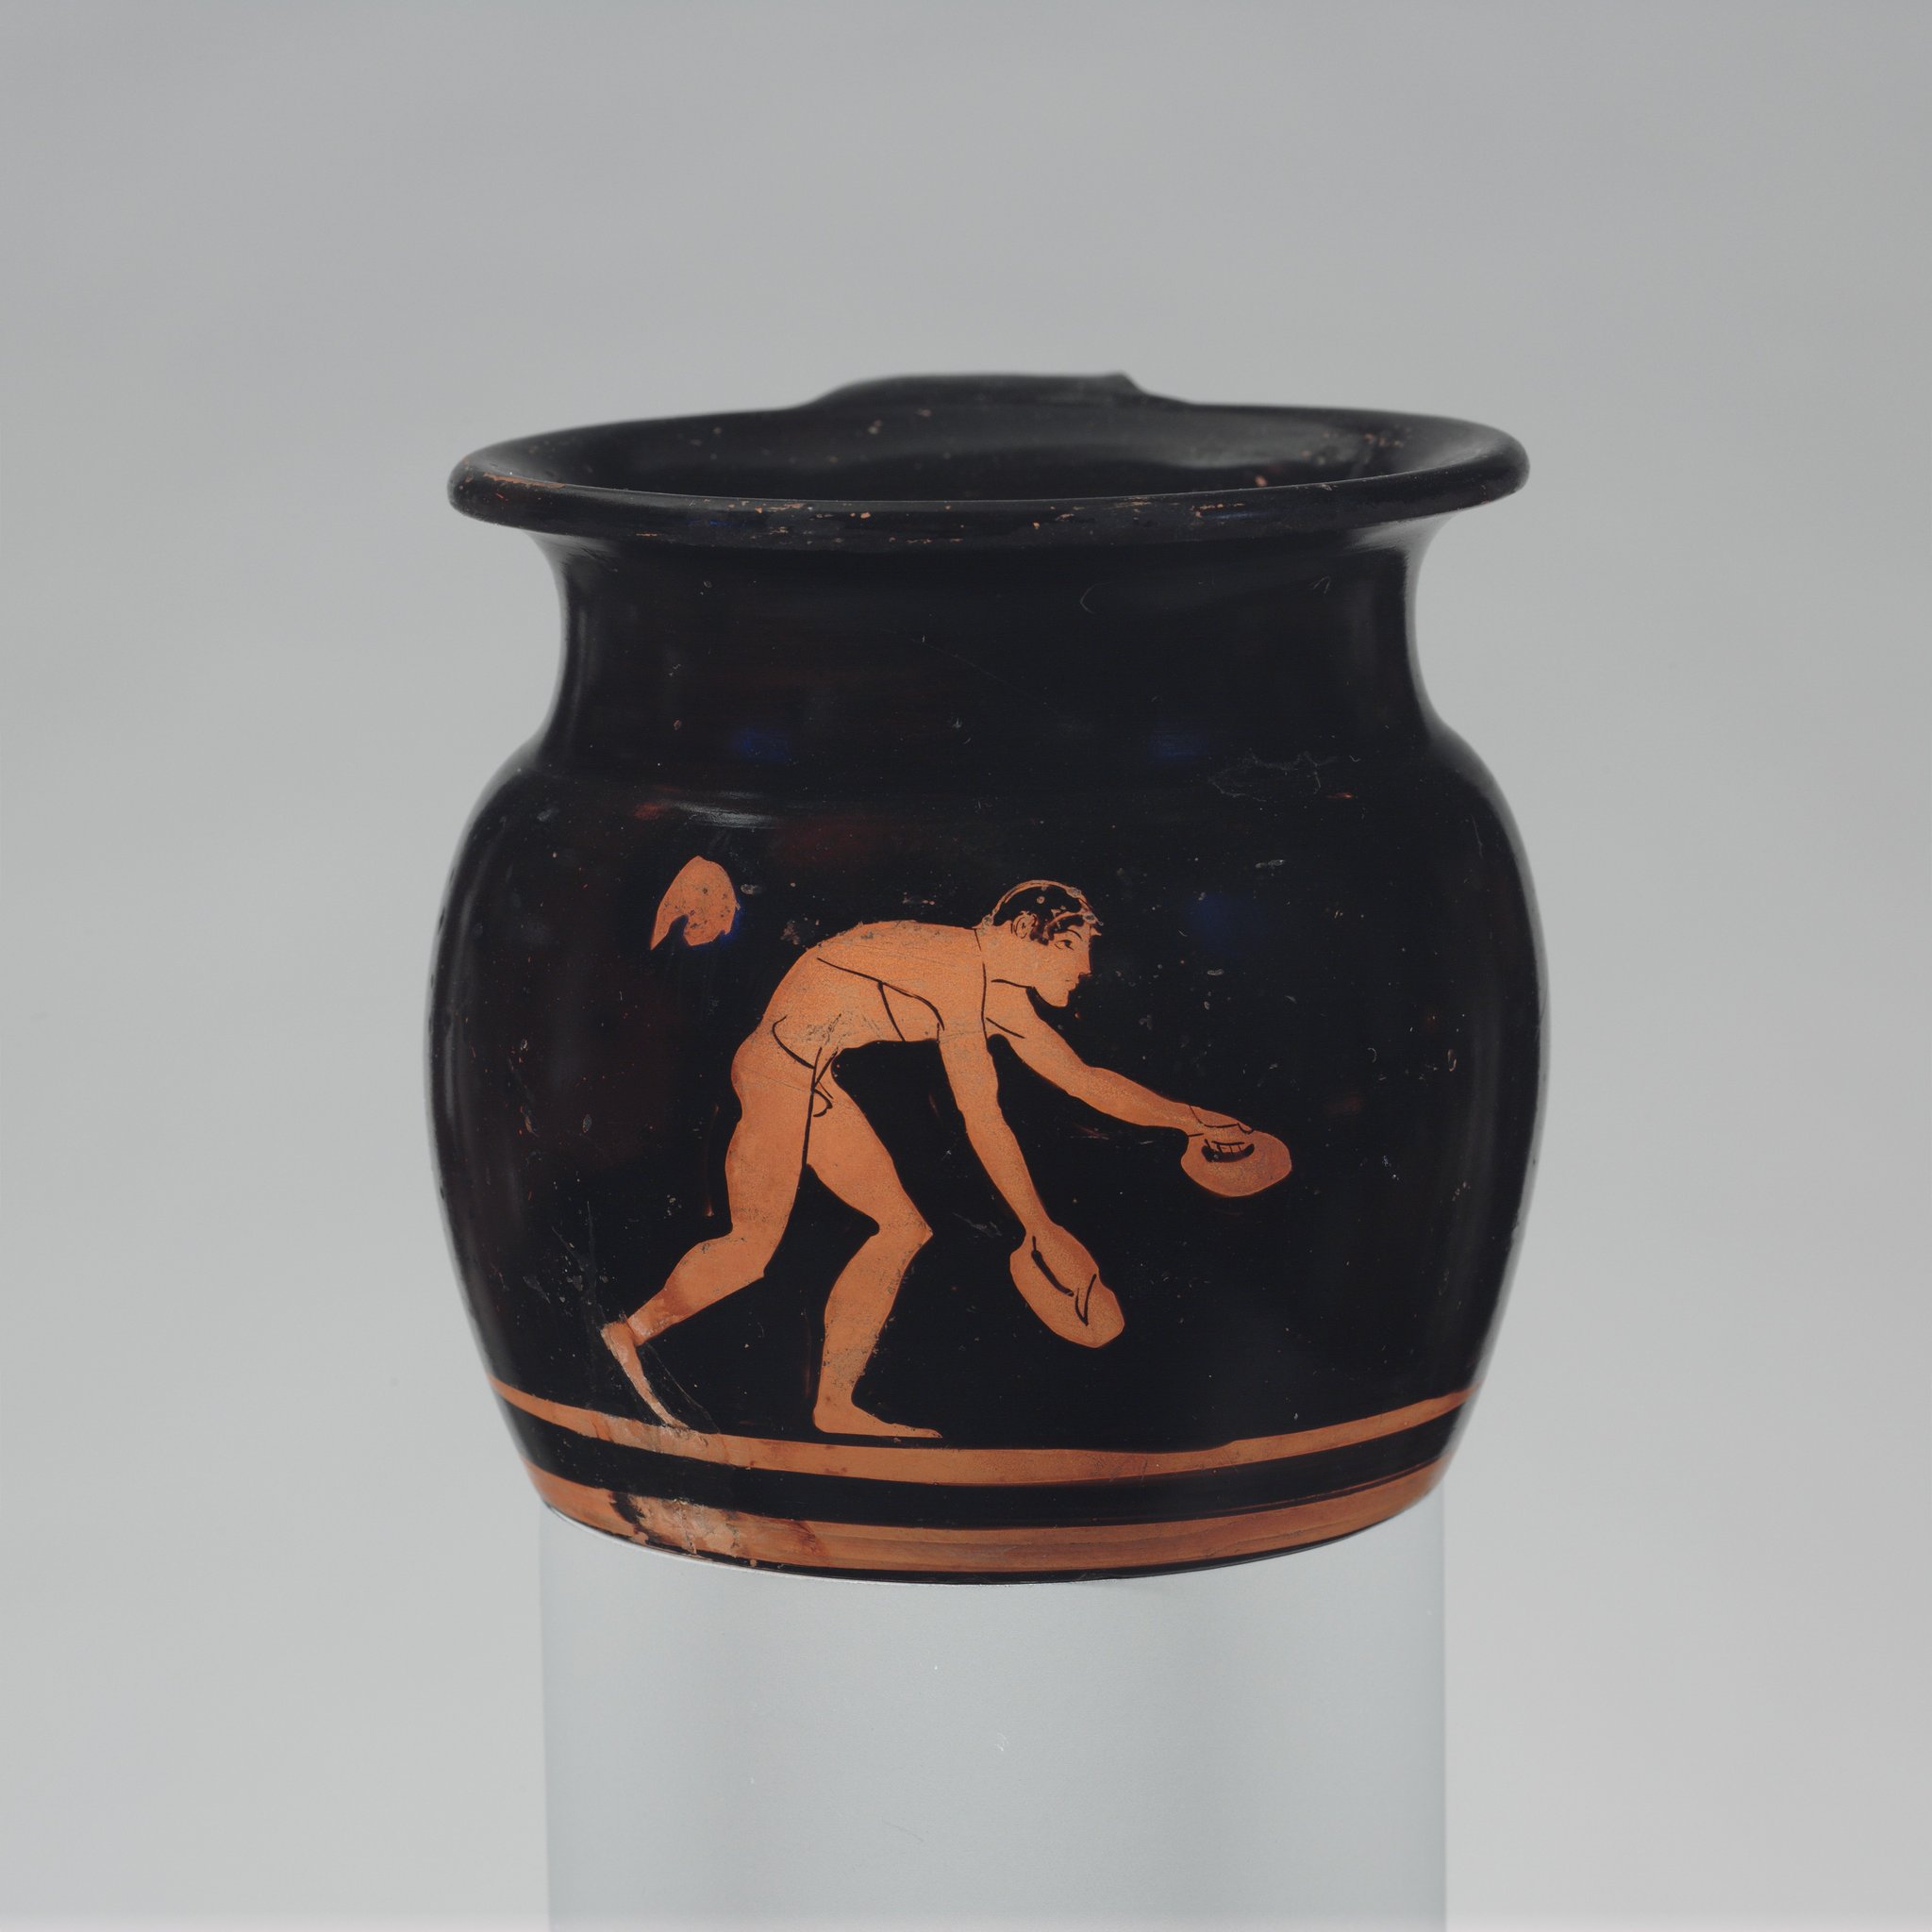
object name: mug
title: Terracotta mug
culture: greek, attic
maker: group of philadelphia 2272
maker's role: artist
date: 460 BCE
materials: terracotta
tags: men,athletes